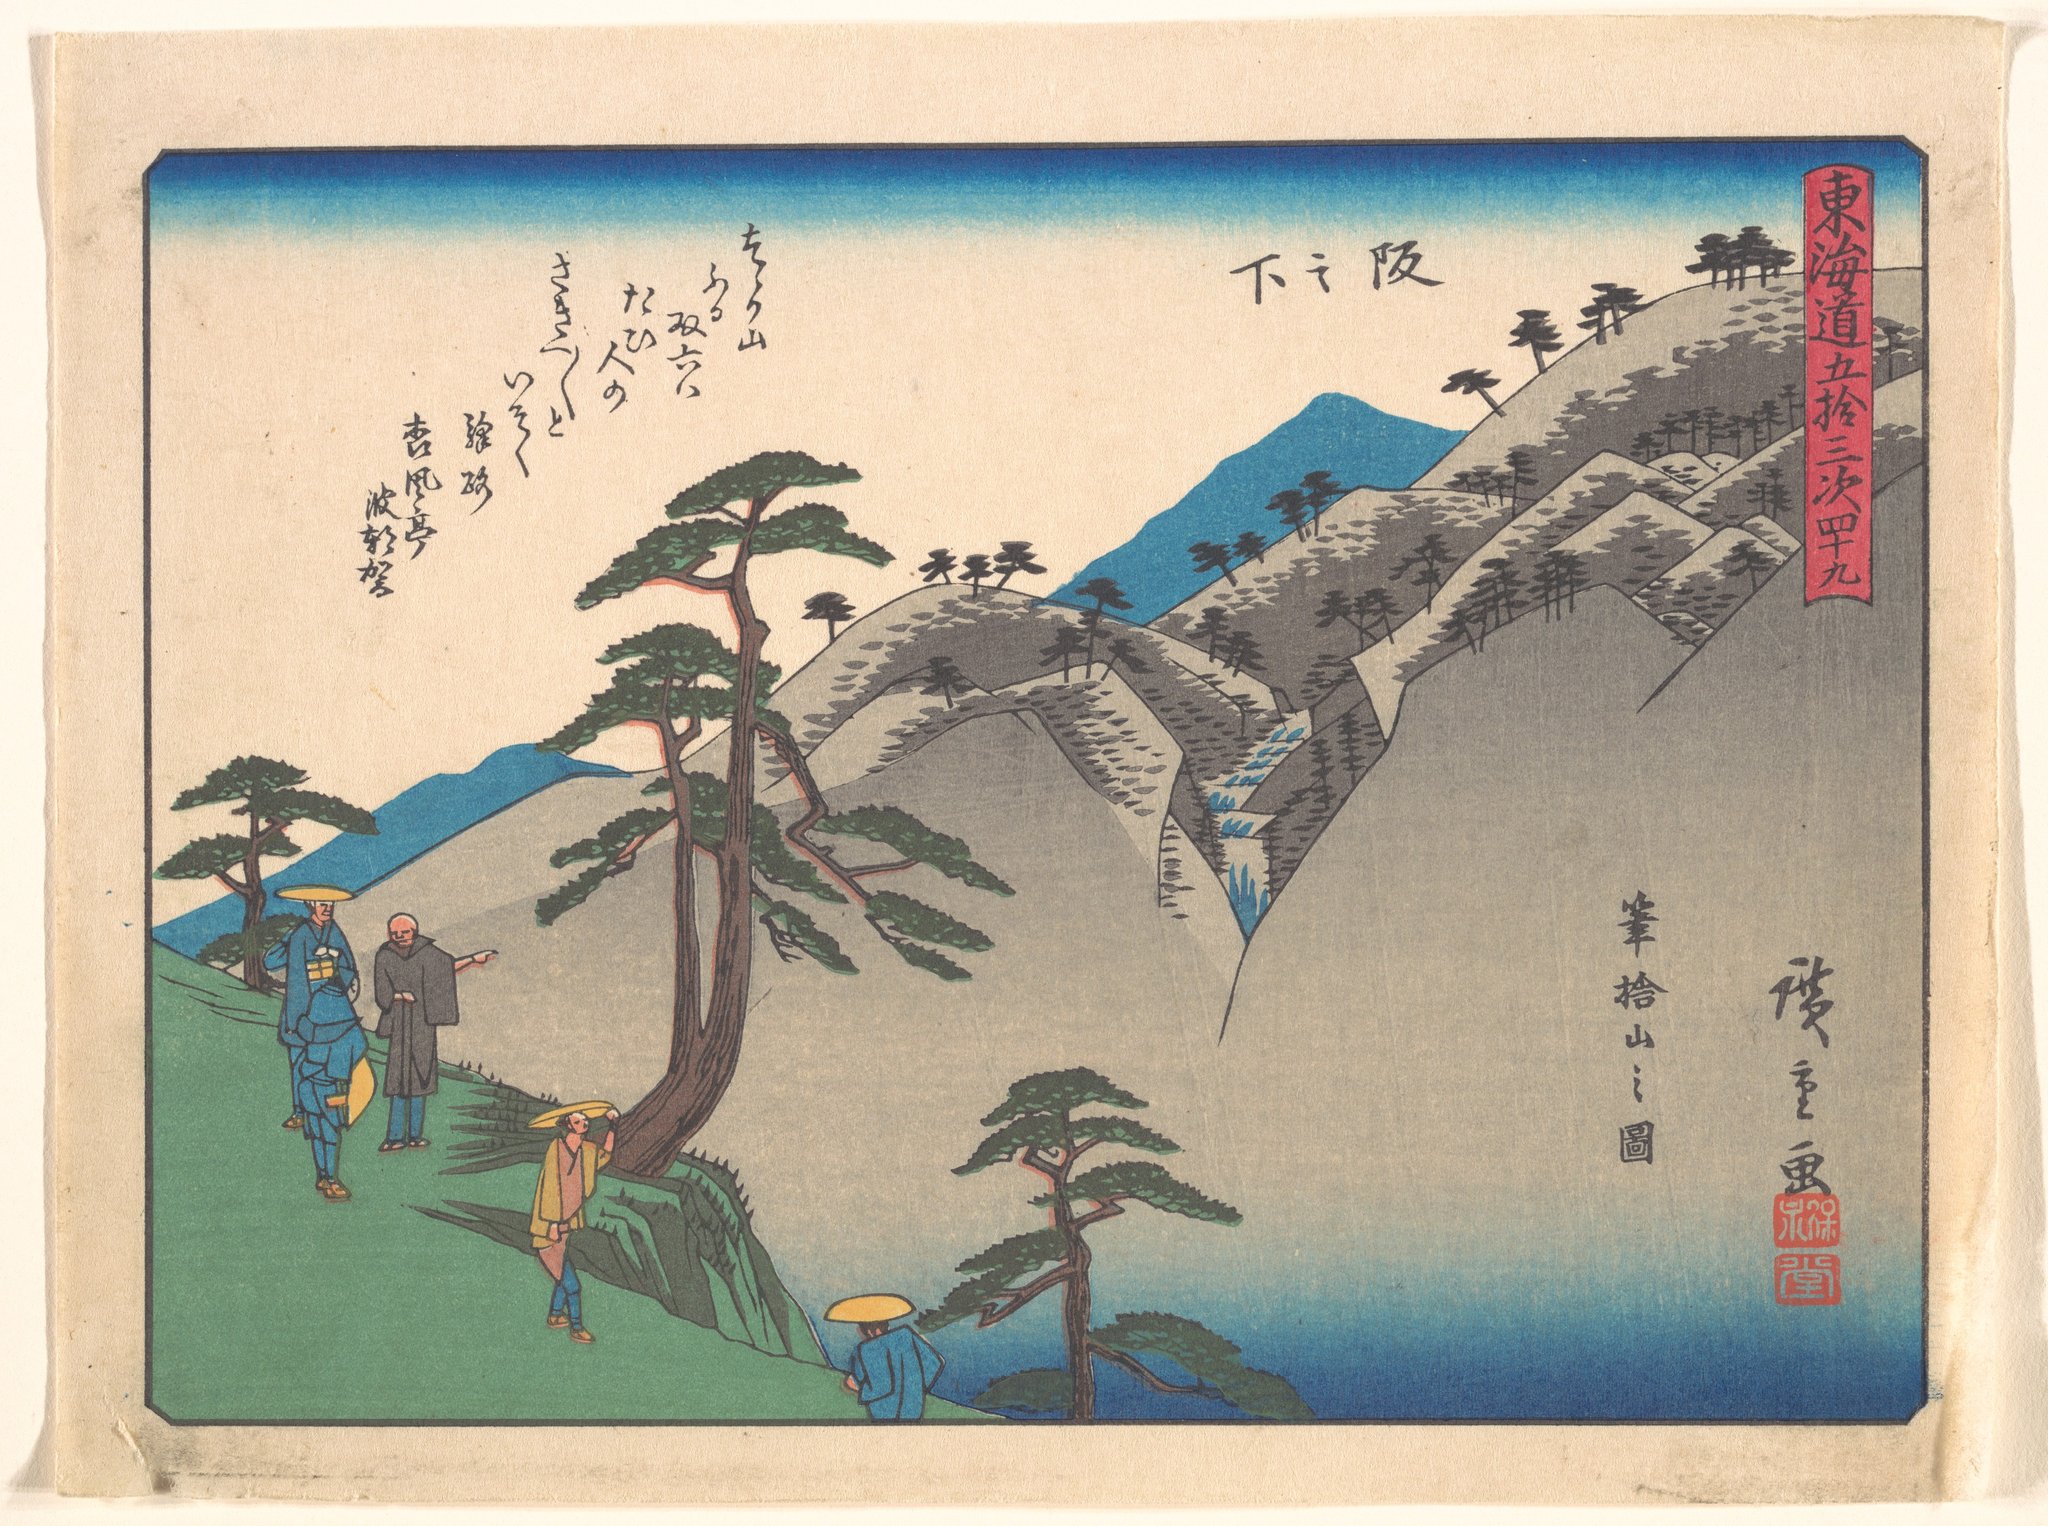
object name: print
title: Sakanoshita, from the series The Fifty-three Stations of the Tōkaidō Road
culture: japanese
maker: utagawa hiroshige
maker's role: artist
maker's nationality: japanese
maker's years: 1797-1858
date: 1901-1933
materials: ink, paper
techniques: woodblock print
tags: men,mountains,trees